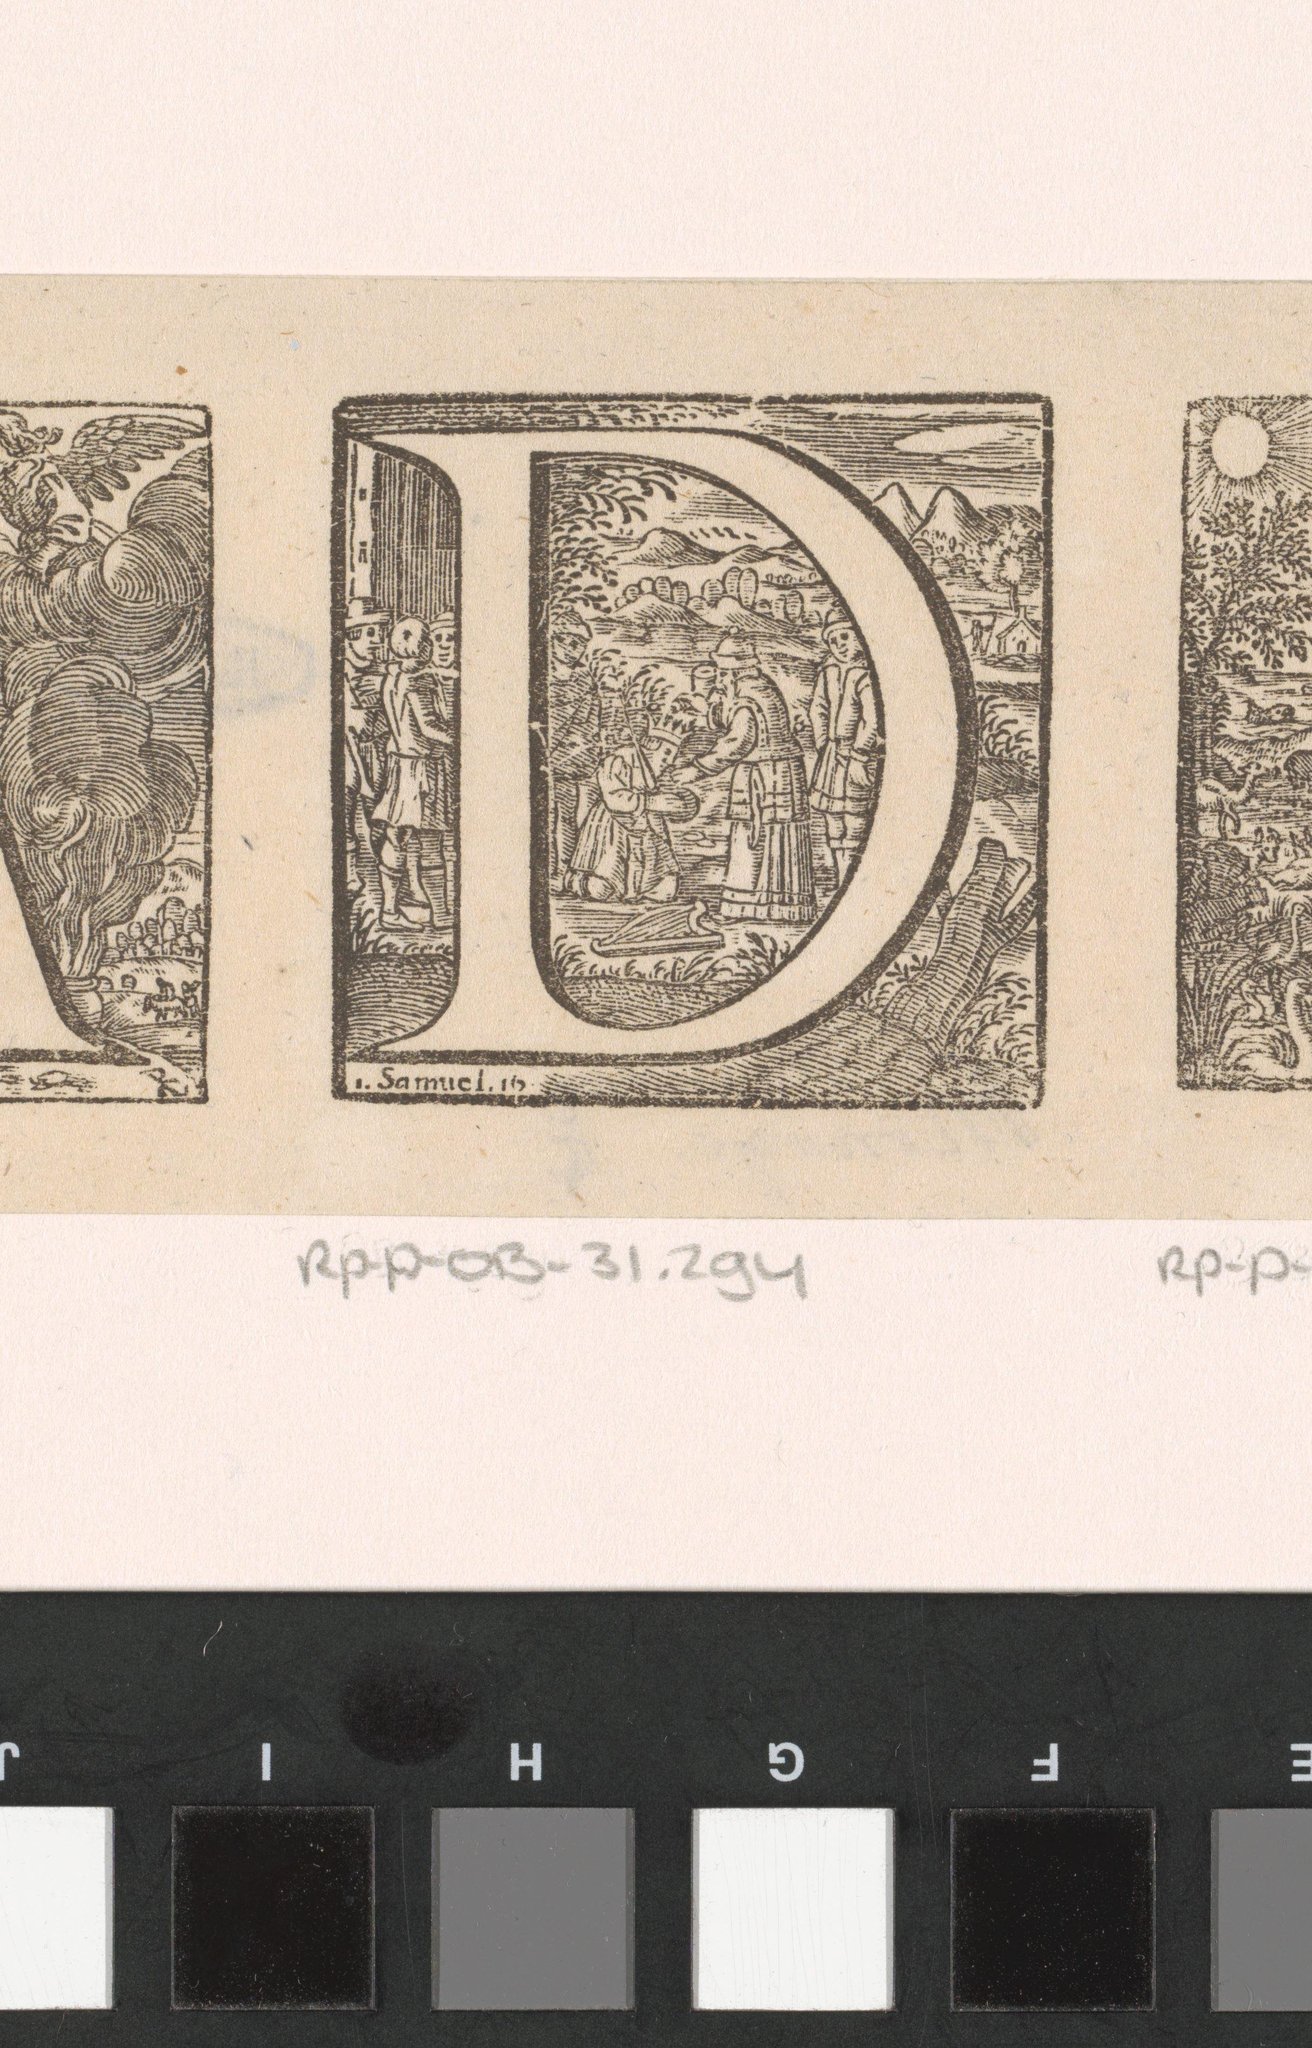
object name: print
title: Letter D in een omlijsting met een voorstelling van David die door Samuël tot koning wordt gezalfd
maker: monogrammist pc (graveur)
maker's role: print maker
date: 1800-1899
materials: paper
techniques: woodcut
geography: germany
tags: fancy letters, samuel anointing david in the presence of his father jesse and his brothers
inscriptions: collector's mark: Lugt 2228, collector's mark: Lugt 2760